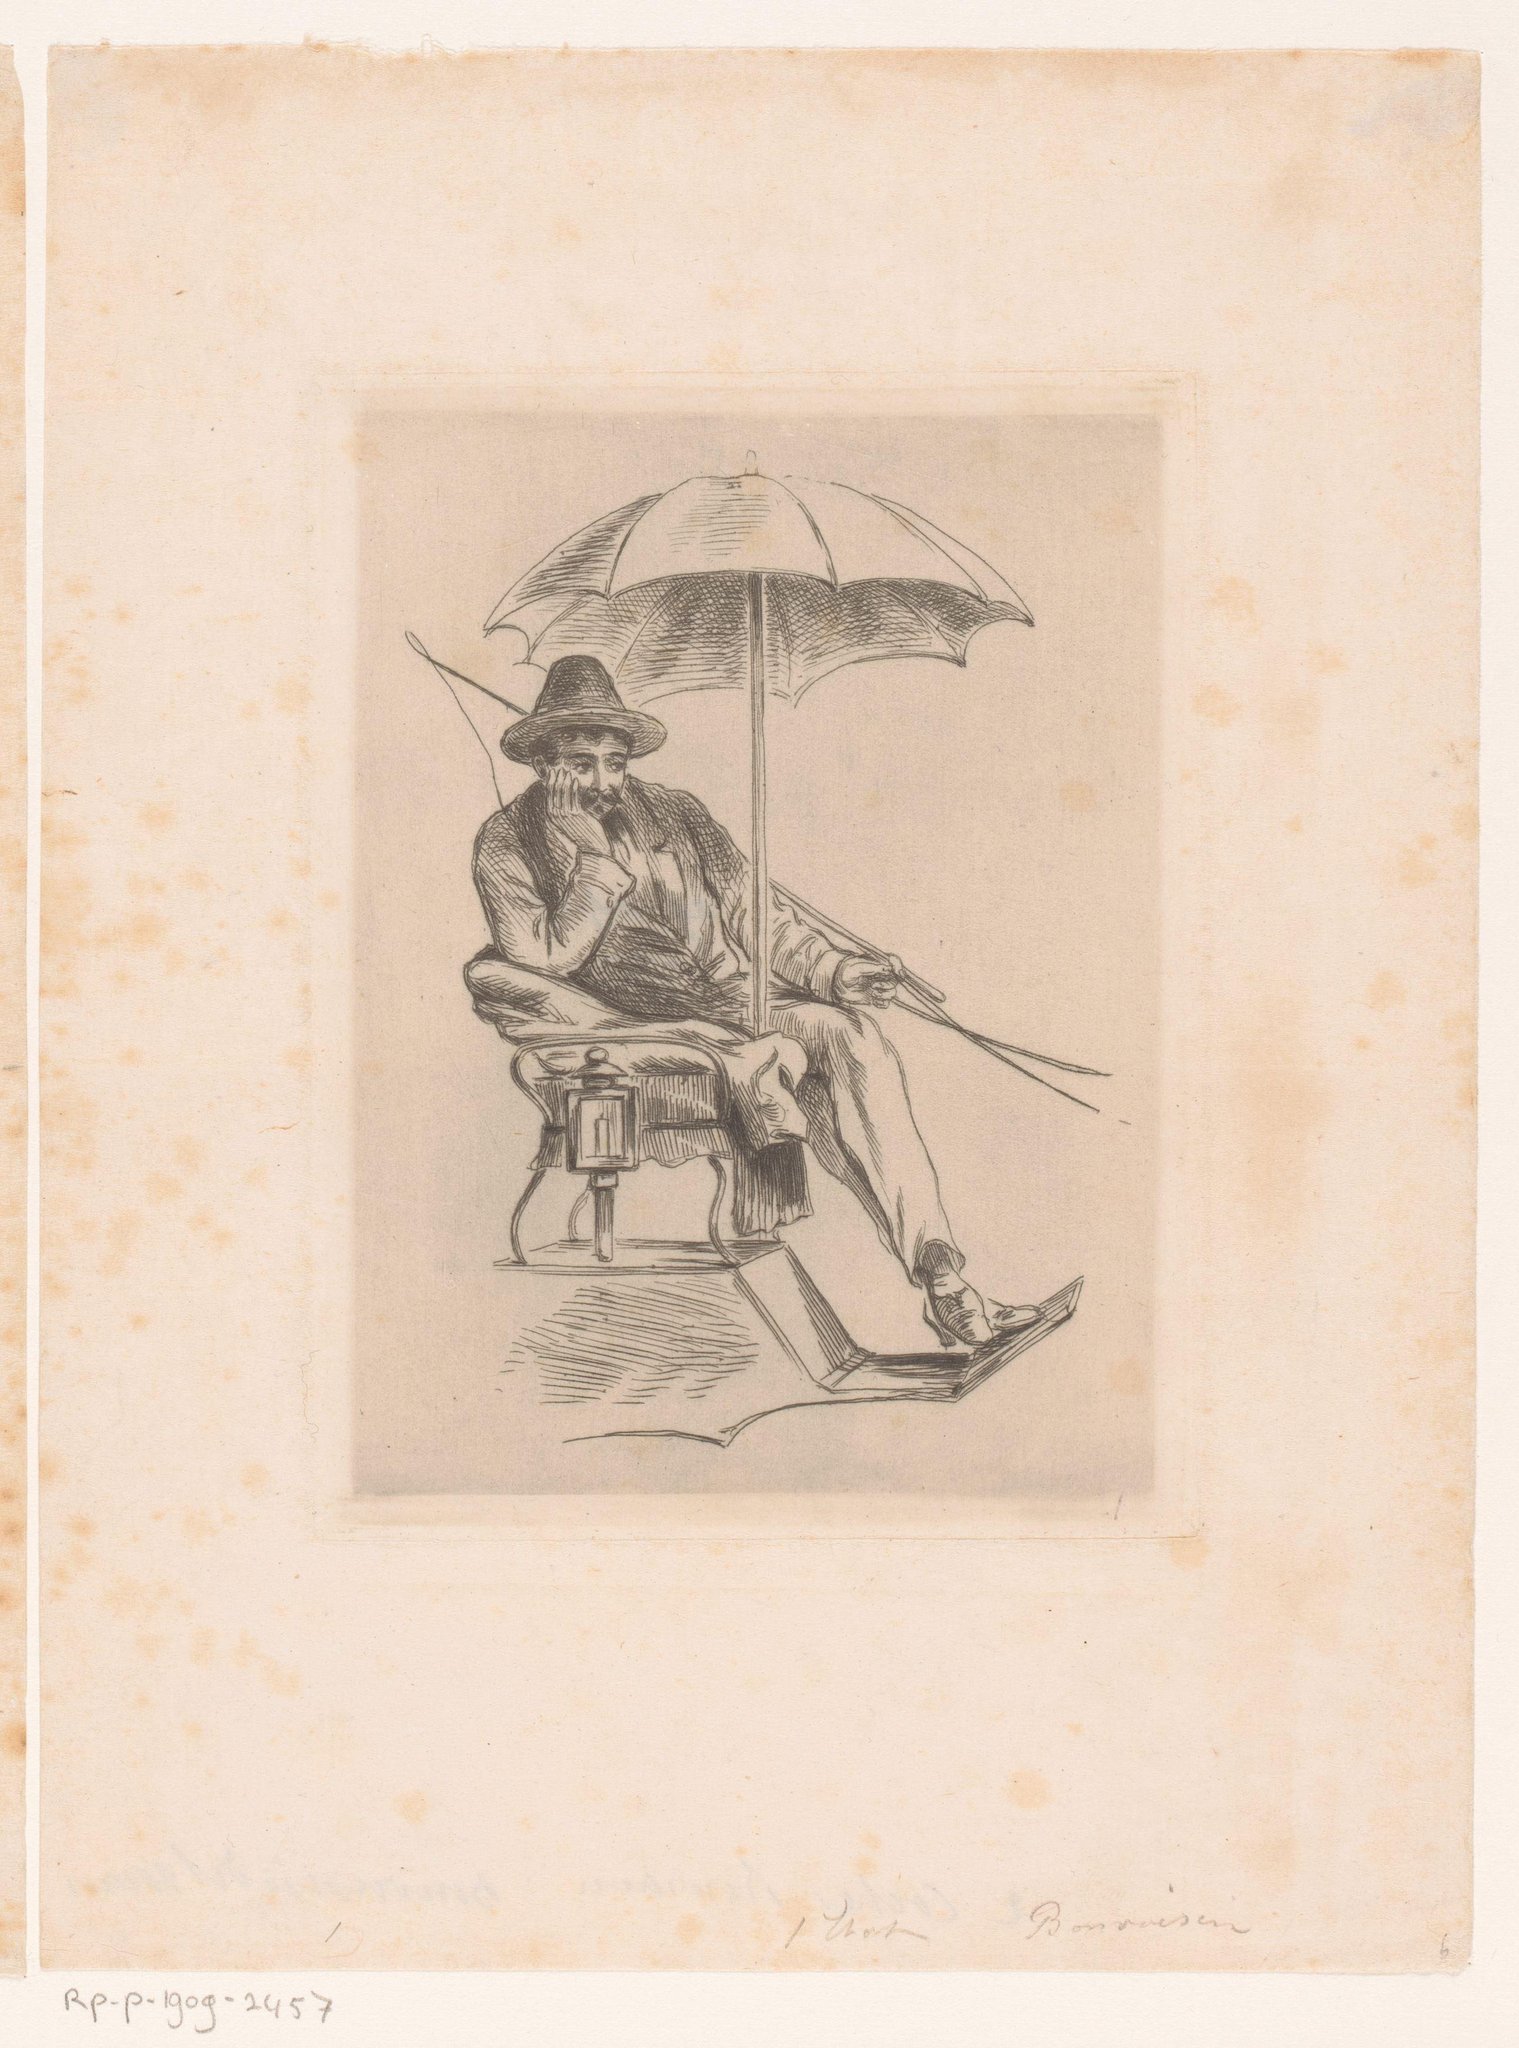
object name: print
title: Man met paraplu op de bok van een rijtuig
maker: maurice bonvoisin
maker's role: print maker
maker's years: 1849-1912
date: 1874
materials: paper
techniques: drypoint, etching, intaglio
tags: animal traction, animal-drawn vehicle (carriage etc.), adult man, umbrella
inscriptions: collector's mark: Lugt 2228